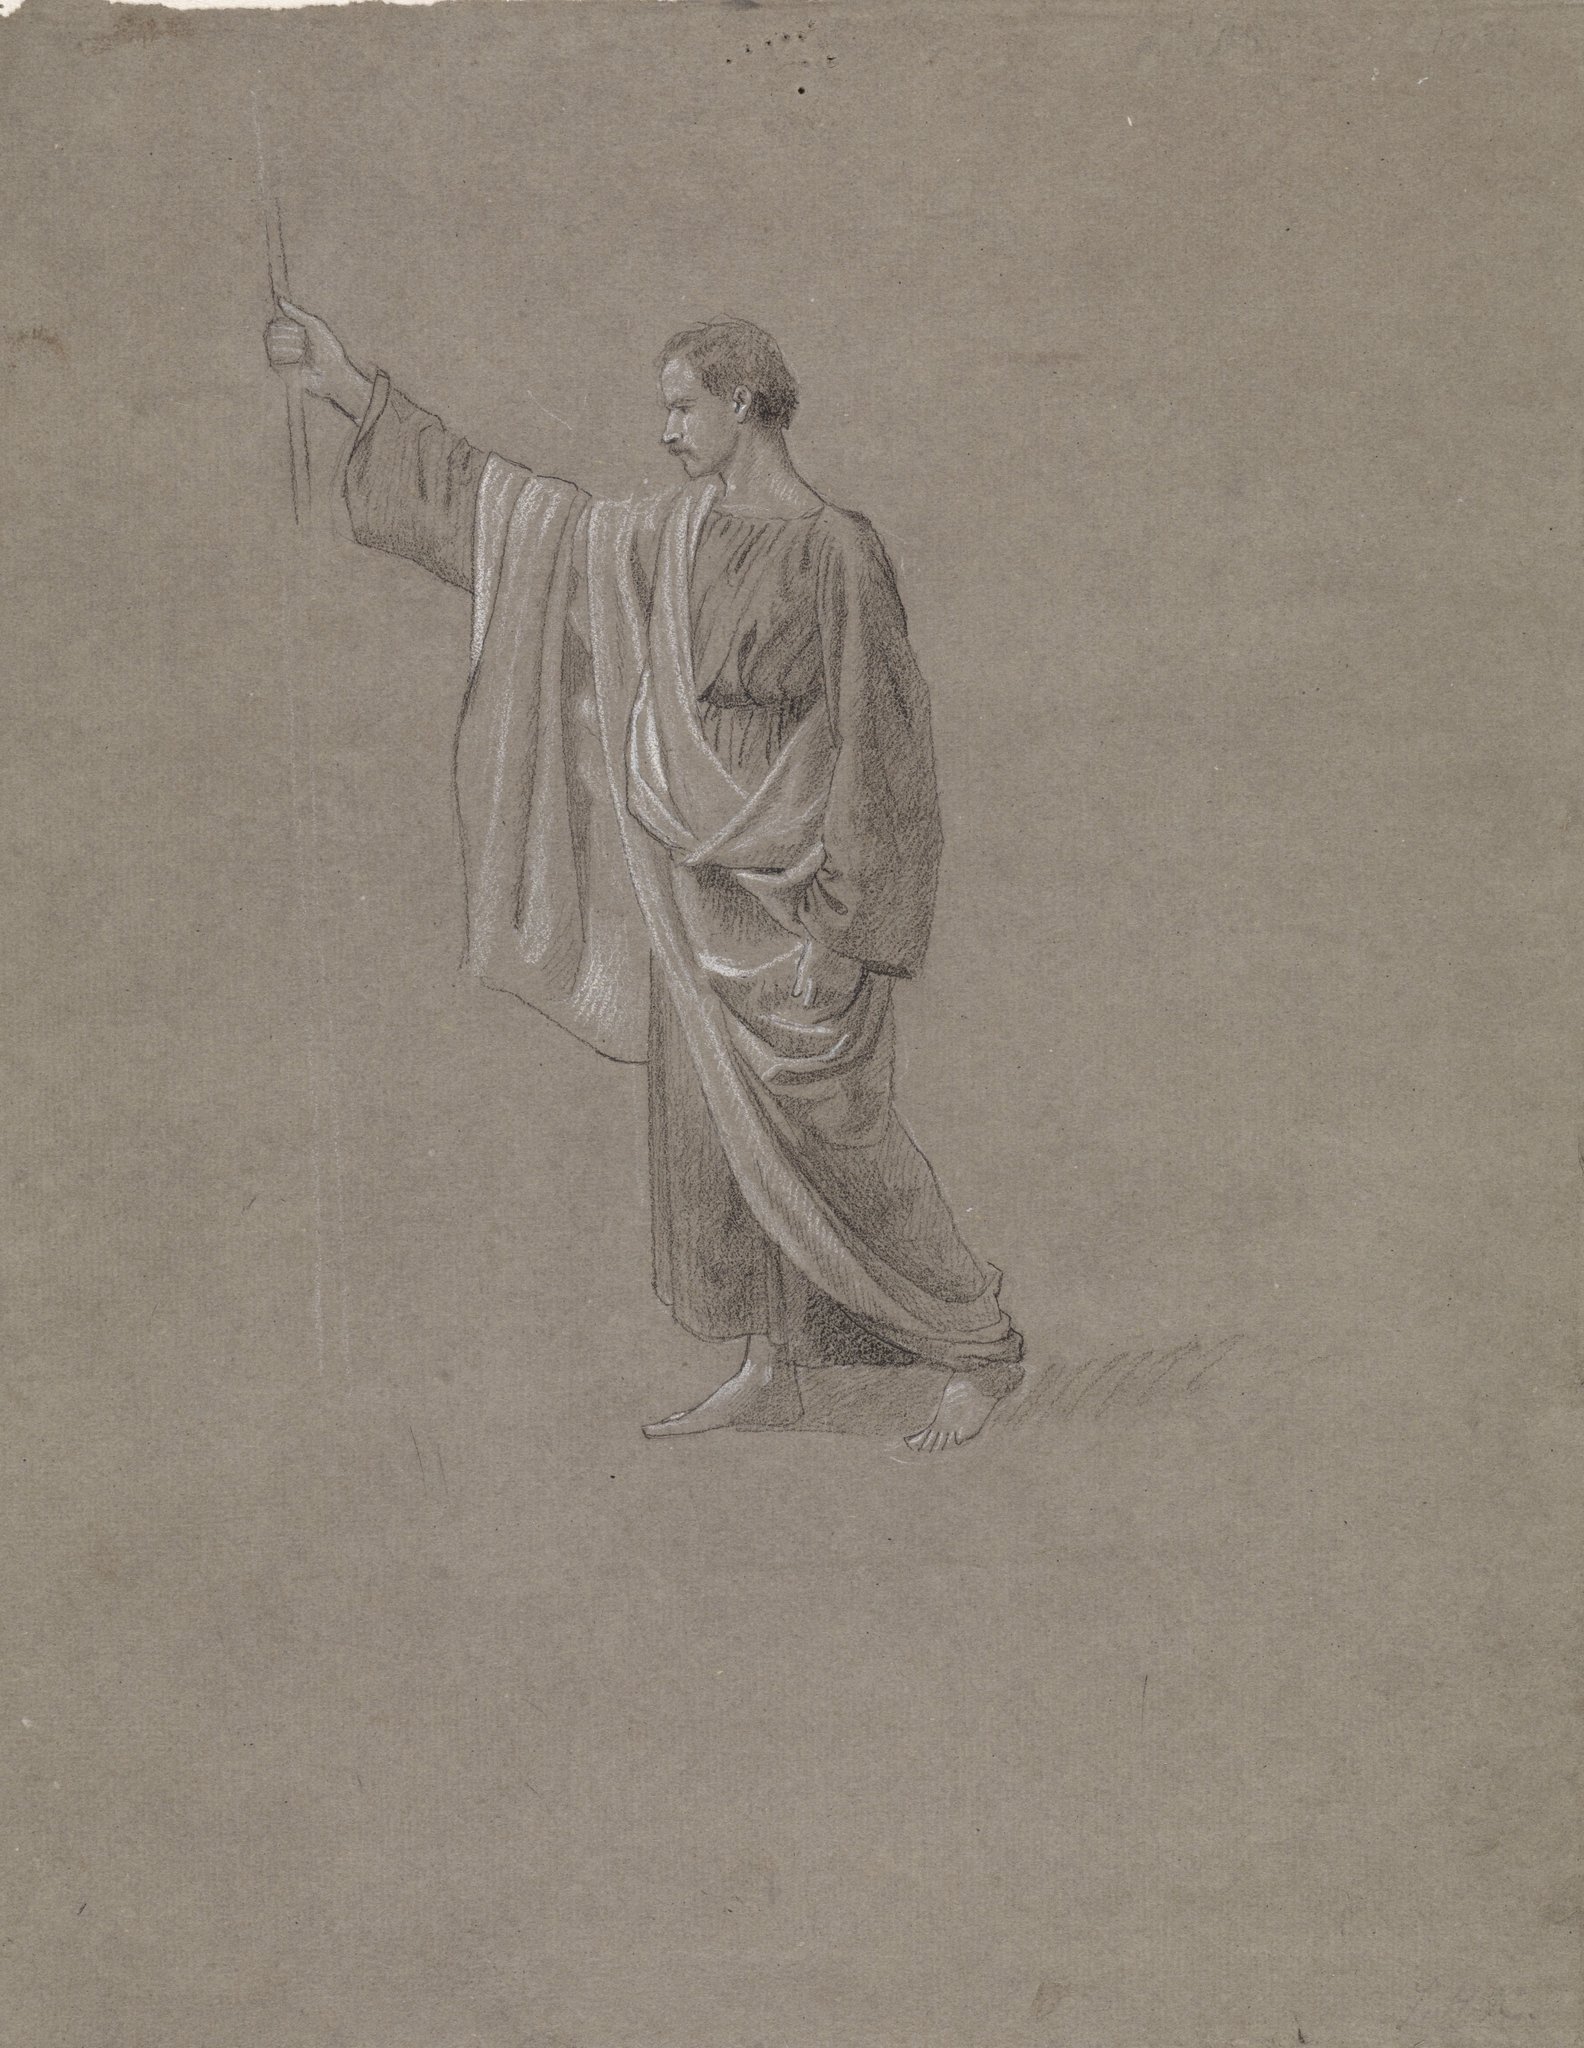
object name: drawing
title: Staande man met staf, naar links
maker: johan hendrik koelman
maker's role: draughtsman, print maker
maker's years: 1820-1887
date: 1830-1887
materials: chalk, paper, pencil